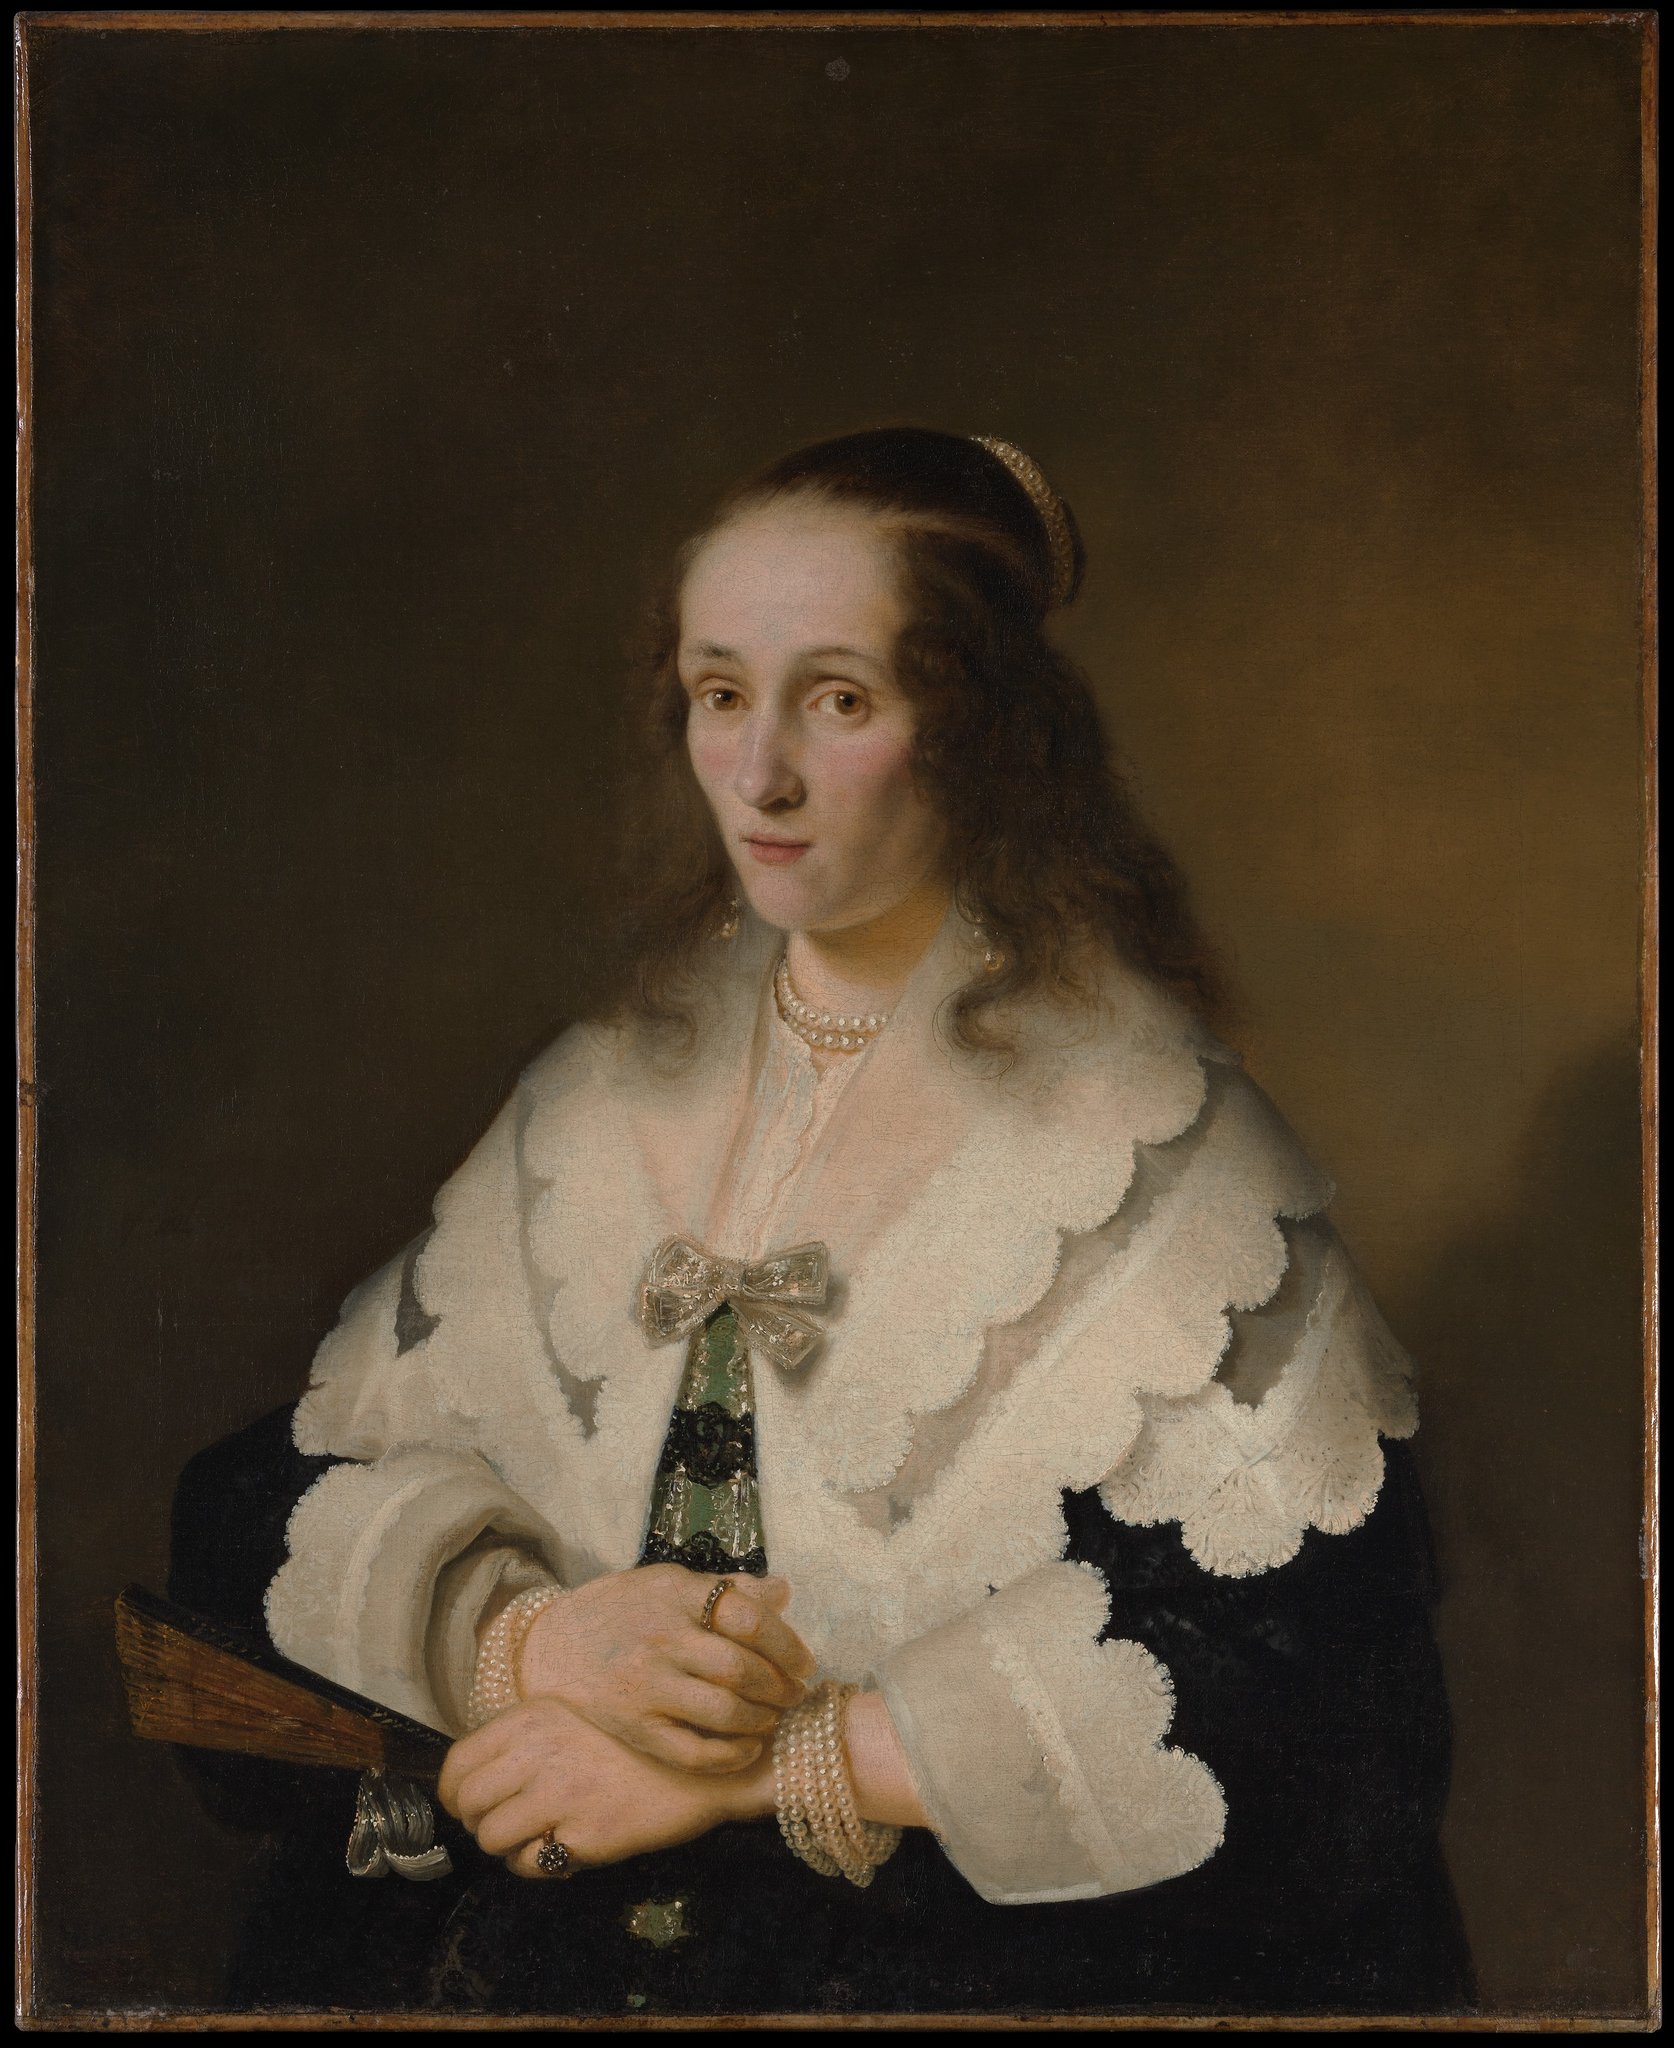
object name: painting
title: Portrait of a Woman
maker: ferdinand bol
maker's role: artist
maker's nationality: dutch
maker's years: 1616-1680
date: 1642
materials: canvas, oil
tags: portraits,women